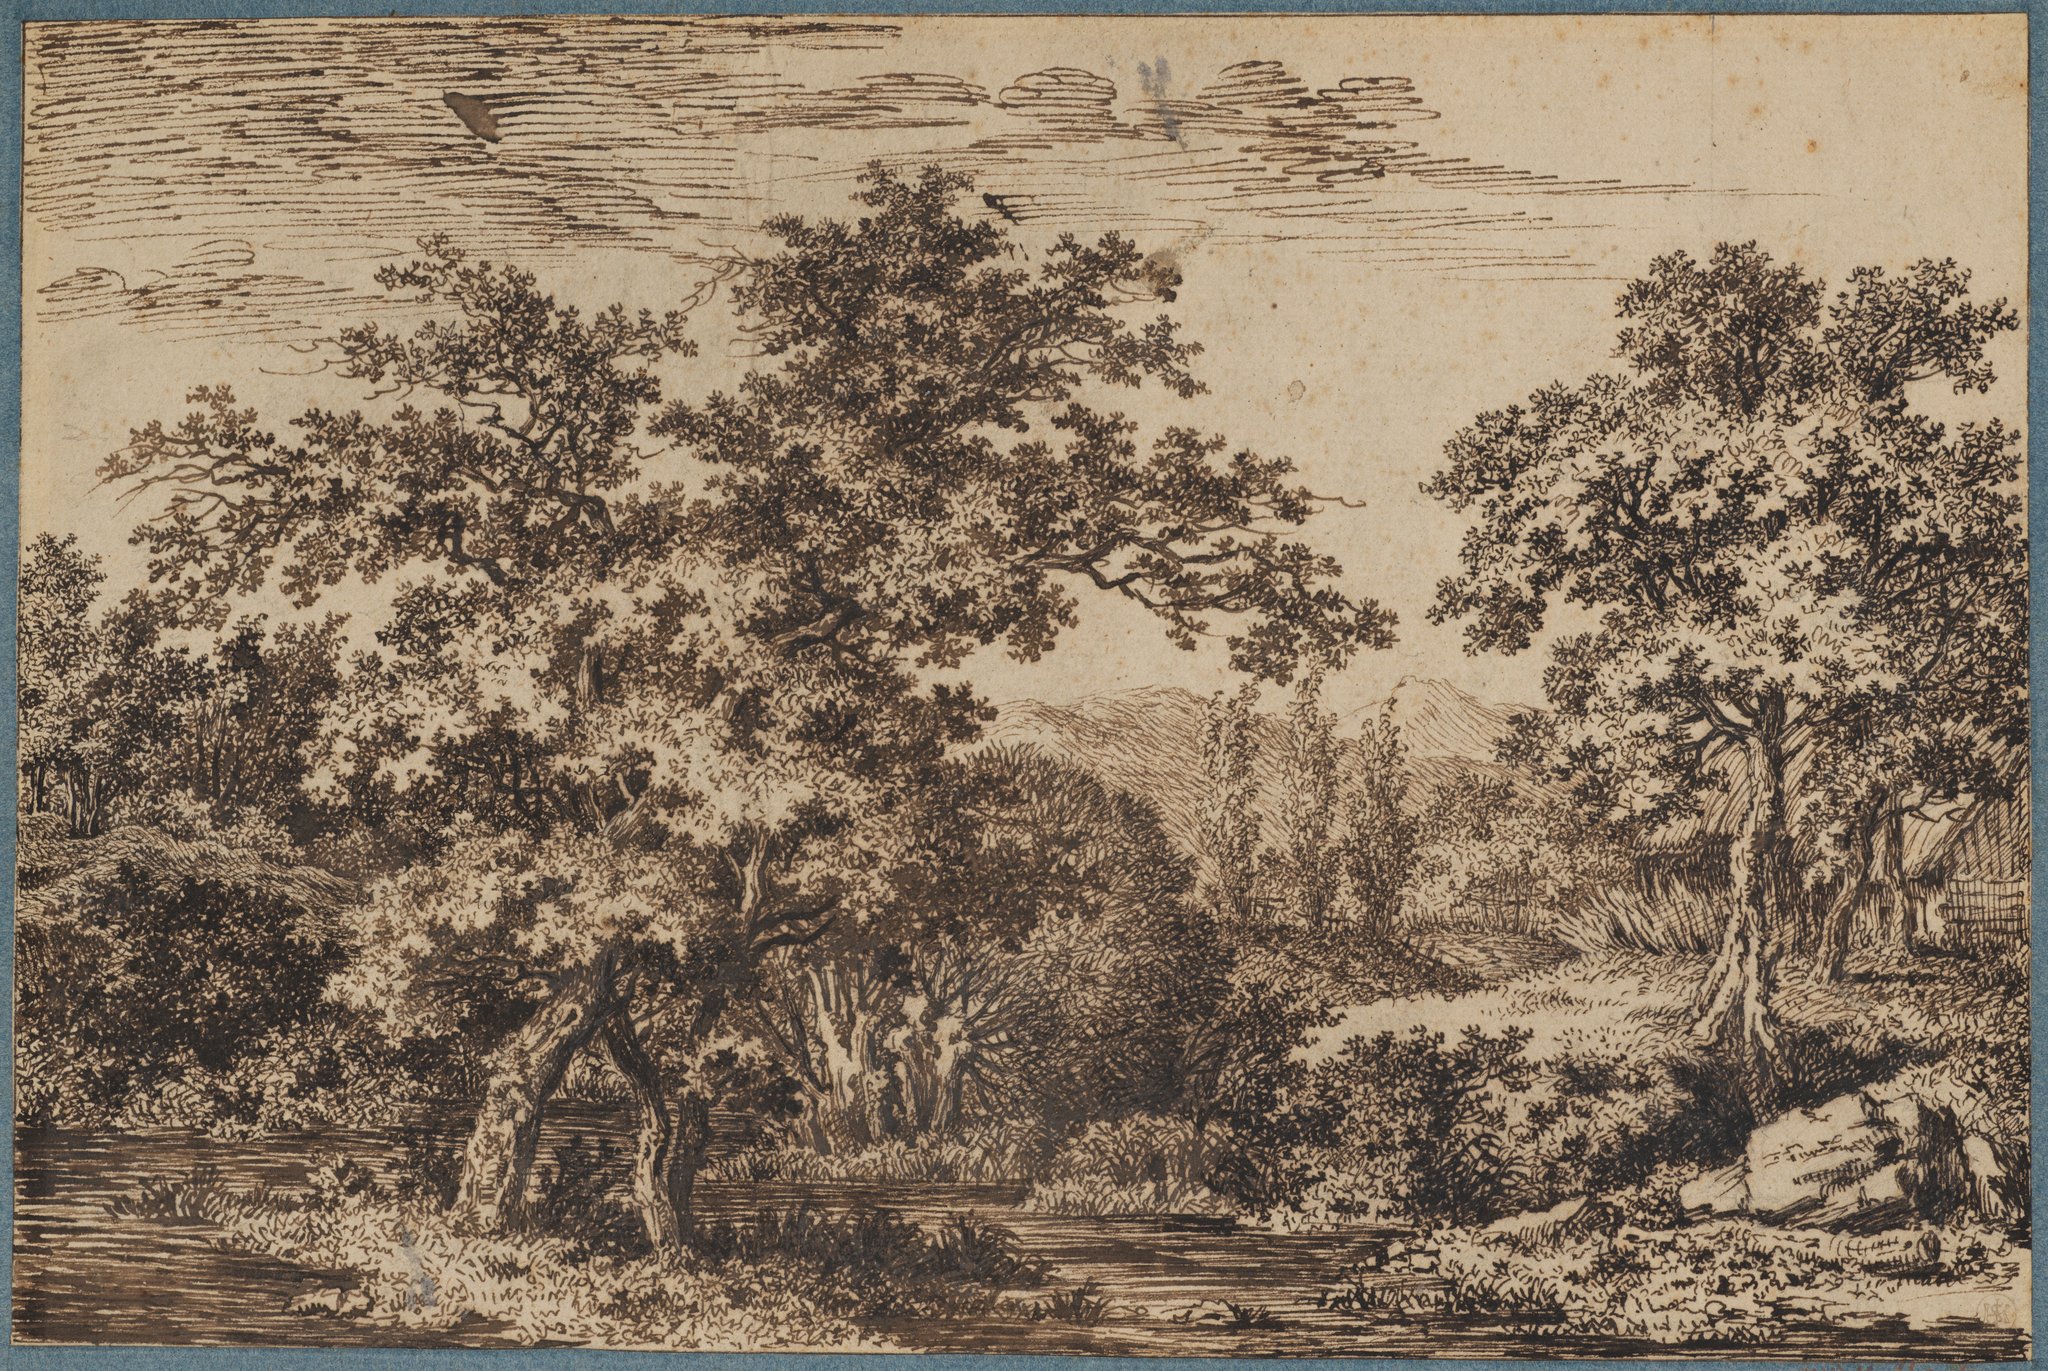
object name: drawing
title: Landscape; a small island with two trees surrounded by water on the left; a tree by a cottage on the right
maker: carl wilhelm kolbe, the elder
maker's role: artist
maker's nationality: german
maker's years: 1759-1835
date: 1793-1794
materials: ink, paper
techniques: pen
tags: landscapes